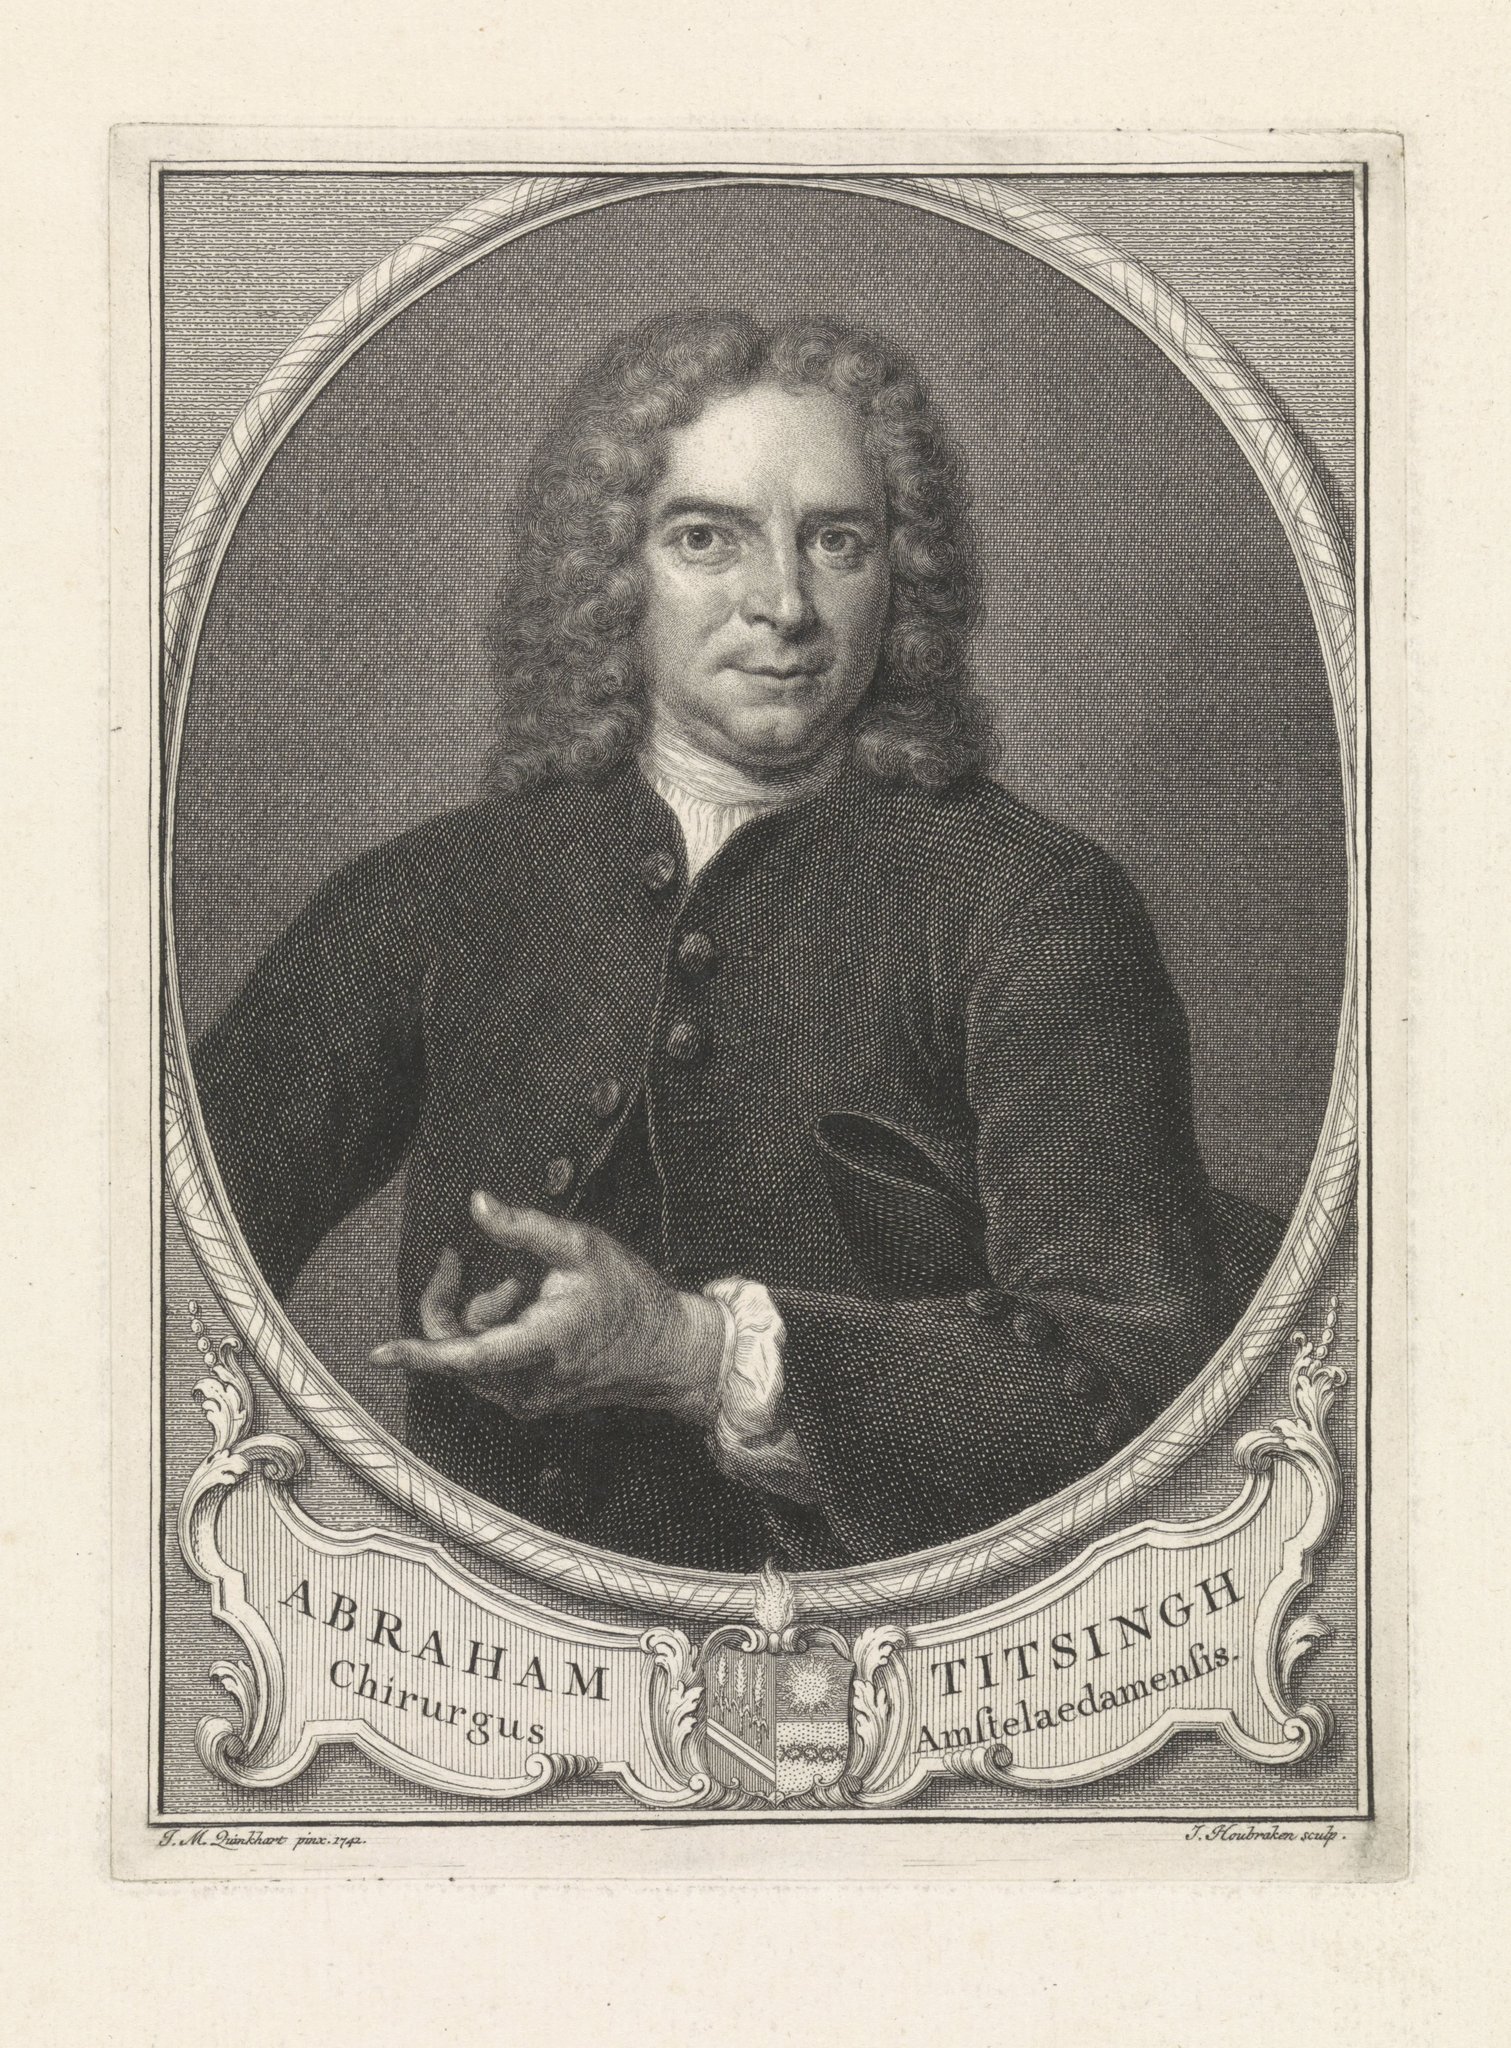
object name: print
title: Portret van Abraham Titsingh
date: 1742-1780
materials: paper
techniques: engraving, etching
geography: amsterdam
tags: chirurg, abraham titsingh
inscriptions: collector's mark: Lugt 240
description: Portret ten halven lijve van Abraham Titsingh in een ovaal medaillon. Onder zijn linkerarm heeft hij zijn hoed geklemd. Onder het portret een cartouche waarop zijn familiewapen en zijn naam en titel in twee regels in het Nederlands.